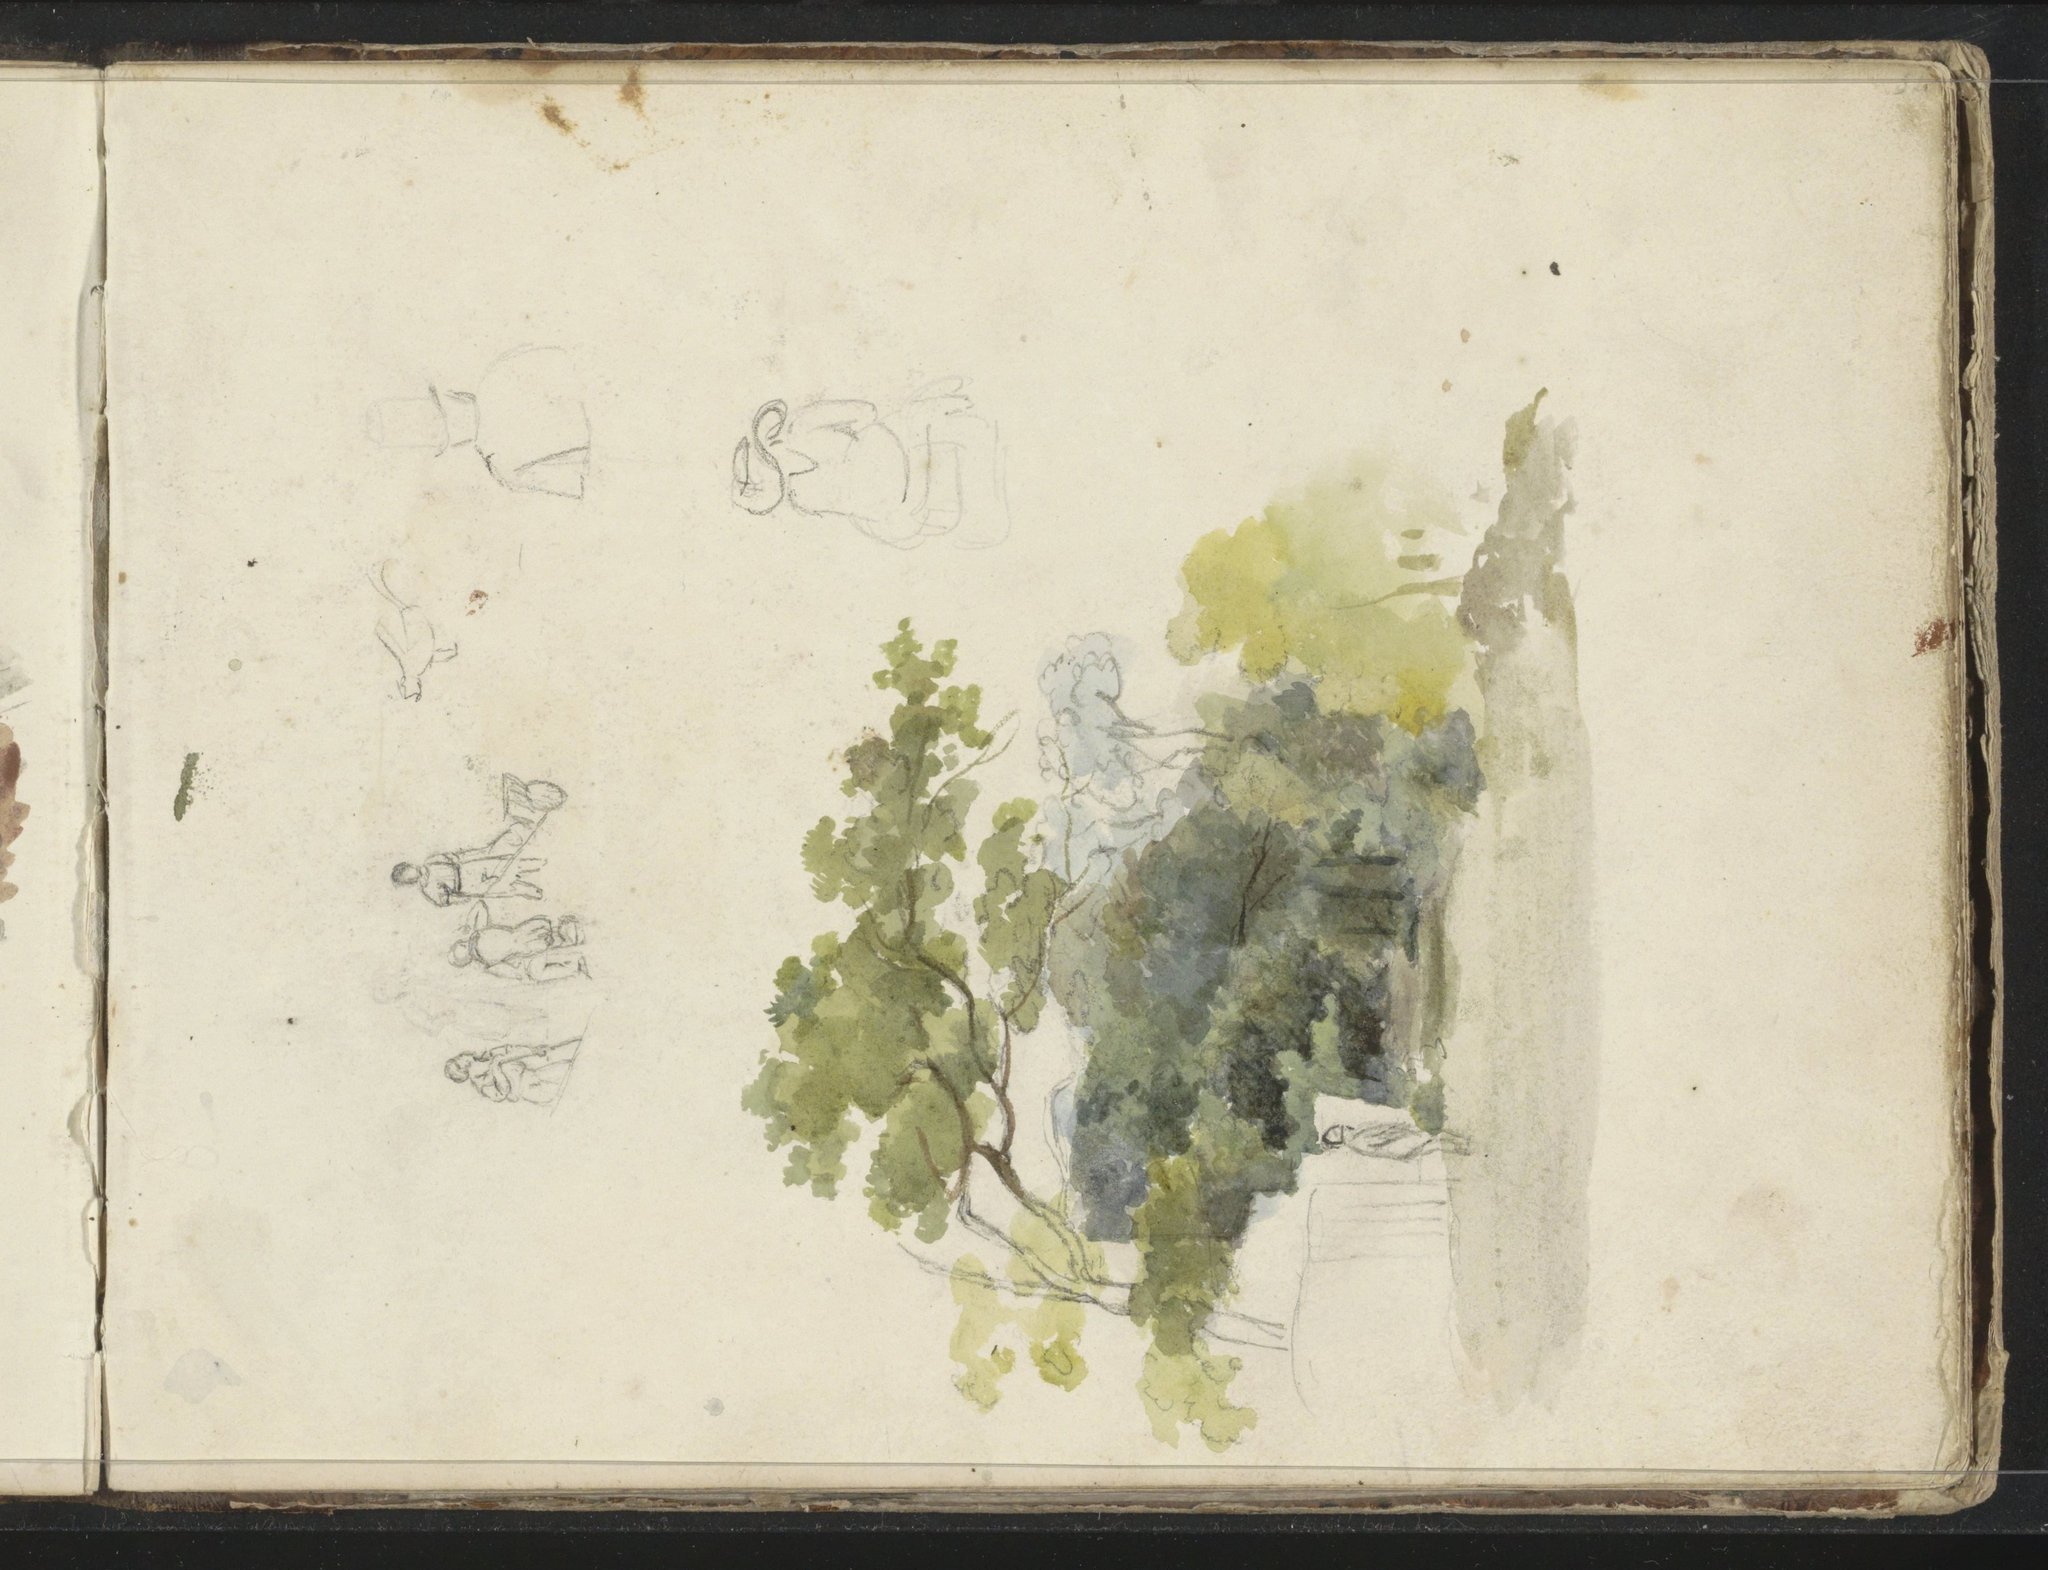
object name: sketchbook leaf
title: Figuren en een bospad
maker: willem troost (ii)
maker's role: draughtsman, painter, print maker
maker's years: 1812-1893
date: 1822-1893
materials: paper, pencil, watercolor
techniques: brush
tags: sitting figure, wheelbarrow (+ one person ~ traffic and transport), forest path or lane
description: Onder andere studies van een jongen of man met een kruiwagen en zittende figuren. Blad 54 recto uit een schetsboek met 36 bladen.